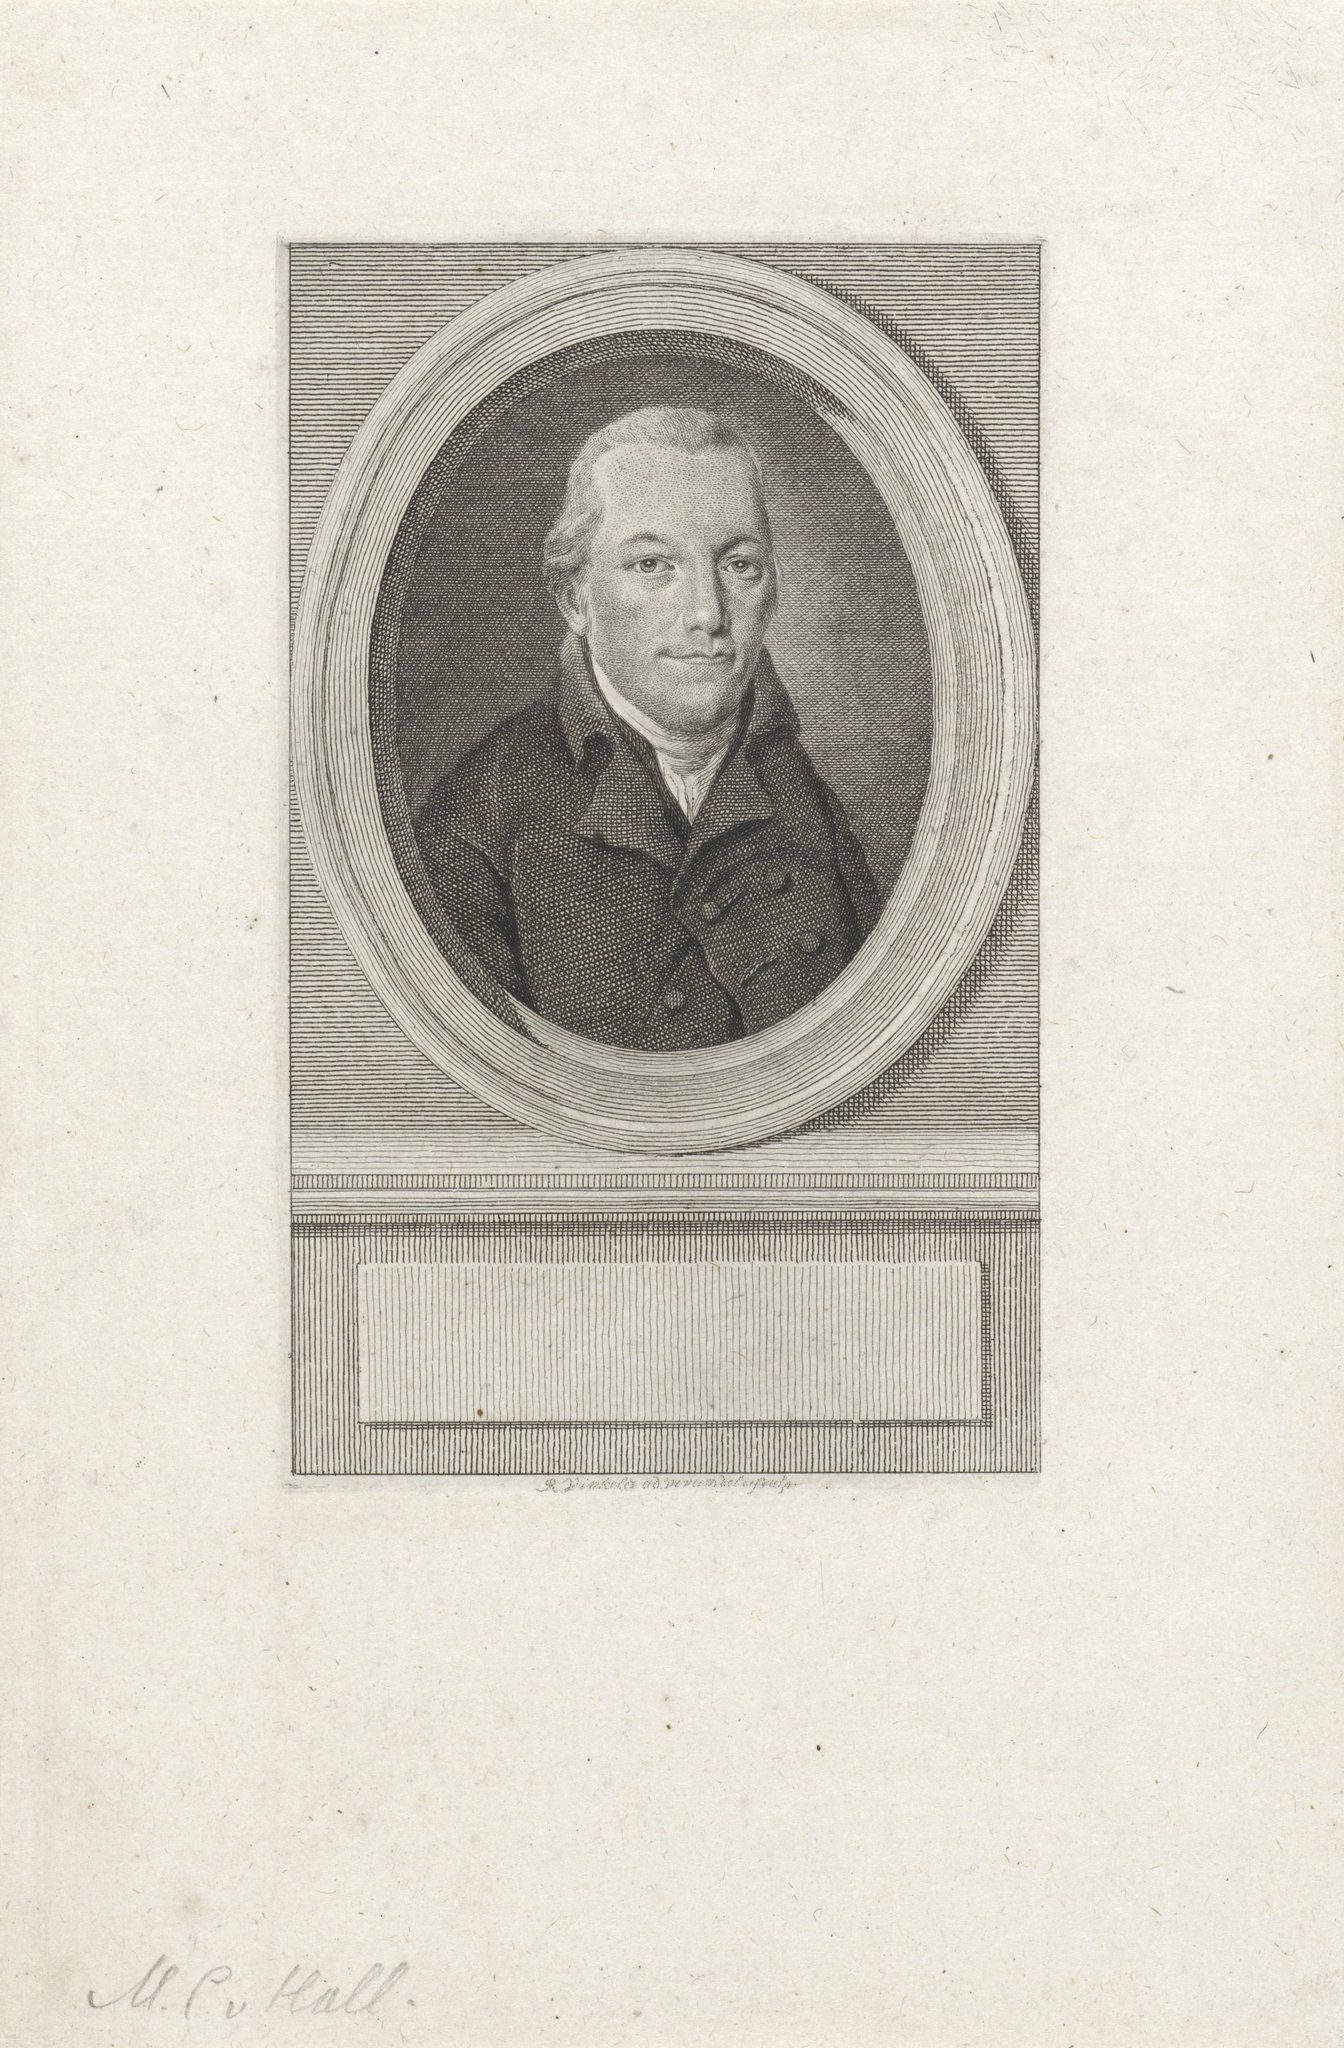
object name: print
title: Portret van Maurits Cornelis van Hall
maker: reinier vinkeles (i)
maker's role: draughtsman, print maker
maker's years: 1741-1816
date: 1786-1809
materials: paper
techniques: etching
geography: amsterdam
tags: amsterdam, maurits cornelis van hall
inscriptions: collector's mark: Lugt 240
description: Latere staat prent ook gebruikt als boekillustratie in: Wagenaar, Jan. Vaderlandsche historie, (...) ten vervolge van Wagenaars Vaderlandsche historie. Dl. 1-43. Amsterdam: Johannes Allart, 1786-1809.